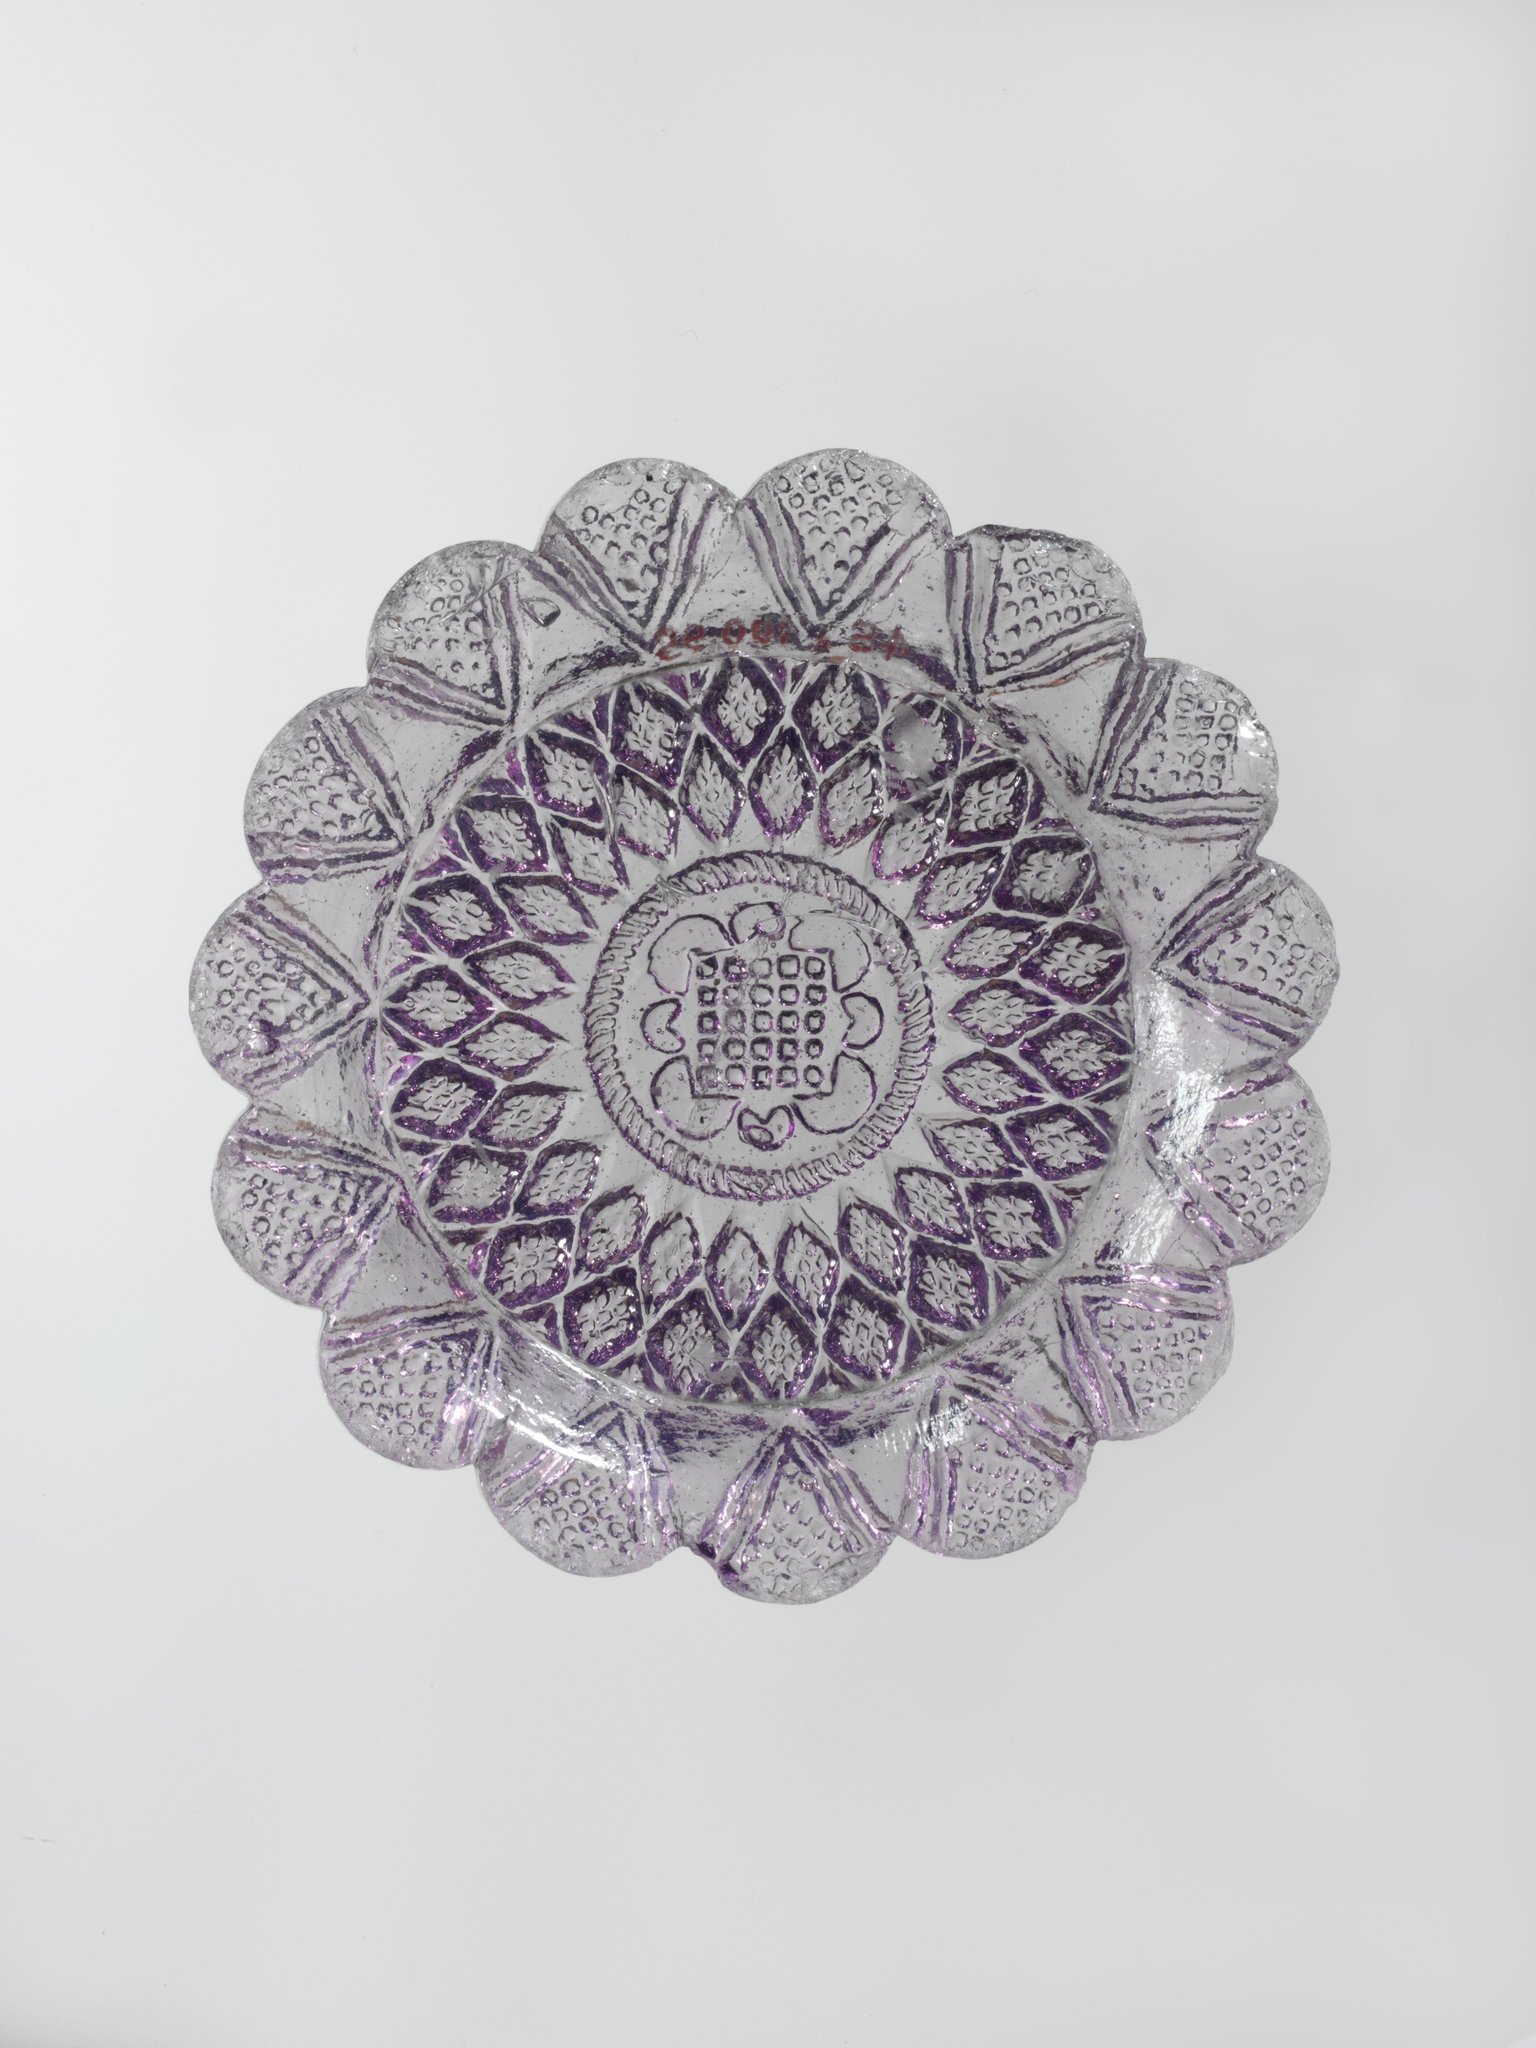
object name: cup plate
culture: american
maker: boston & sandwich glass company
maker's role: maker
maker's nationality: american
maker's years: 1825-1888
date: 1829-1830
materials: glass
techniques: pressed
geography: united states